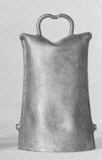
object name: cow bell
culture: german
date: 1850-1889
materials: brass, iron, leather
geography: germany